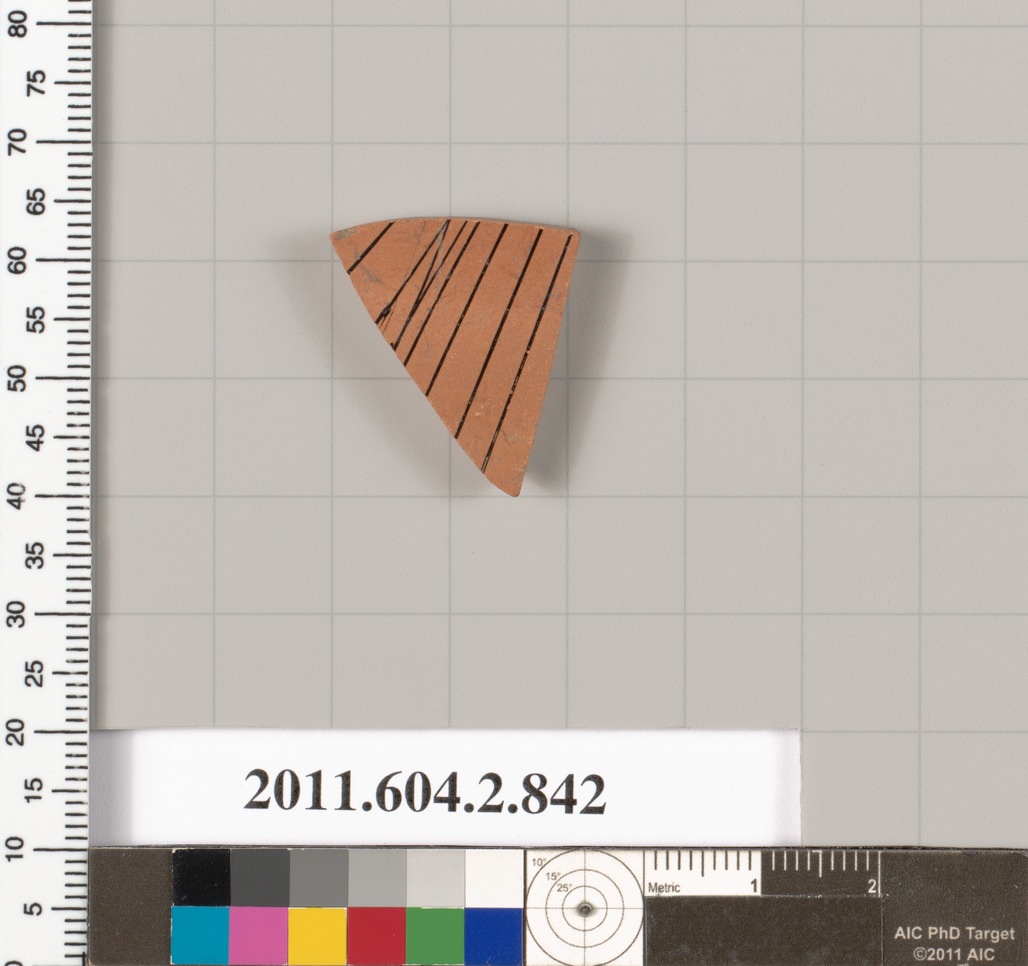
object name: bell krater fragment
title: Terracotta fragment of a bell-krater (bowl for mixing wine and water)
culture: greek, attic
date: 460-450 BCE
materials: terracotta